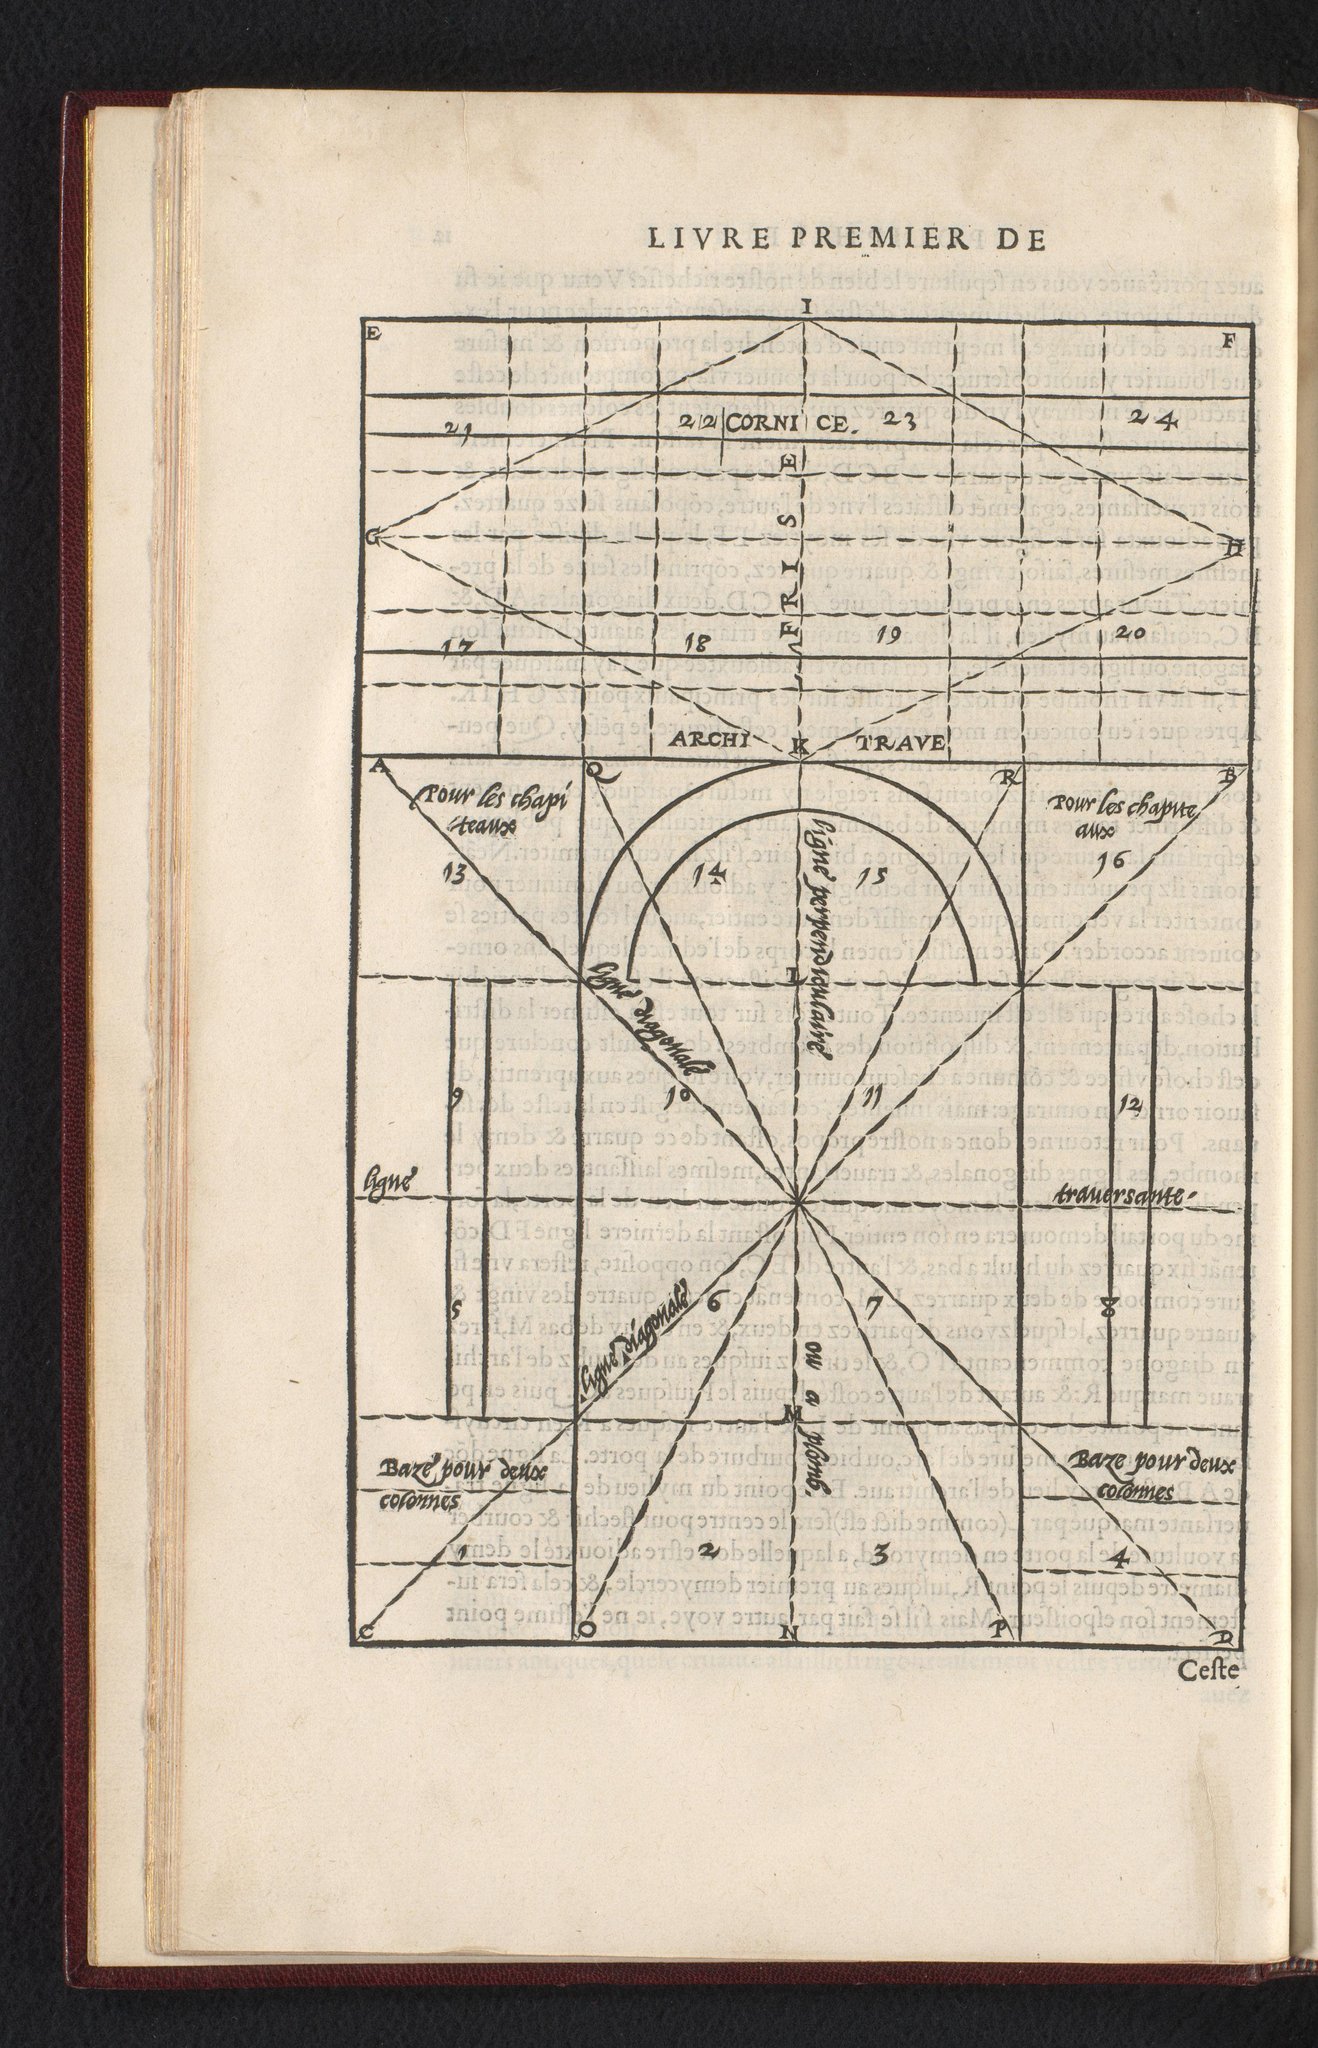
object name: book illustration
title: Ontwerp en verhoudingen van een architectonische boog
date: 1546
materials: paper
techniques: letterpress printing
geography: paris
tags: (scenes from) specific works of literature: colonna, hypnerotomachia poliphili, arch, archivolt ~ architecture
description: Prent uit: Colonna, Francesco. Hypnerotomachie ou discours du songe de Poliphile, deduisant comme amour le combat a l'occasion de Polia. Parijs: Jacques Kerver, 1546, verso fol. 12.